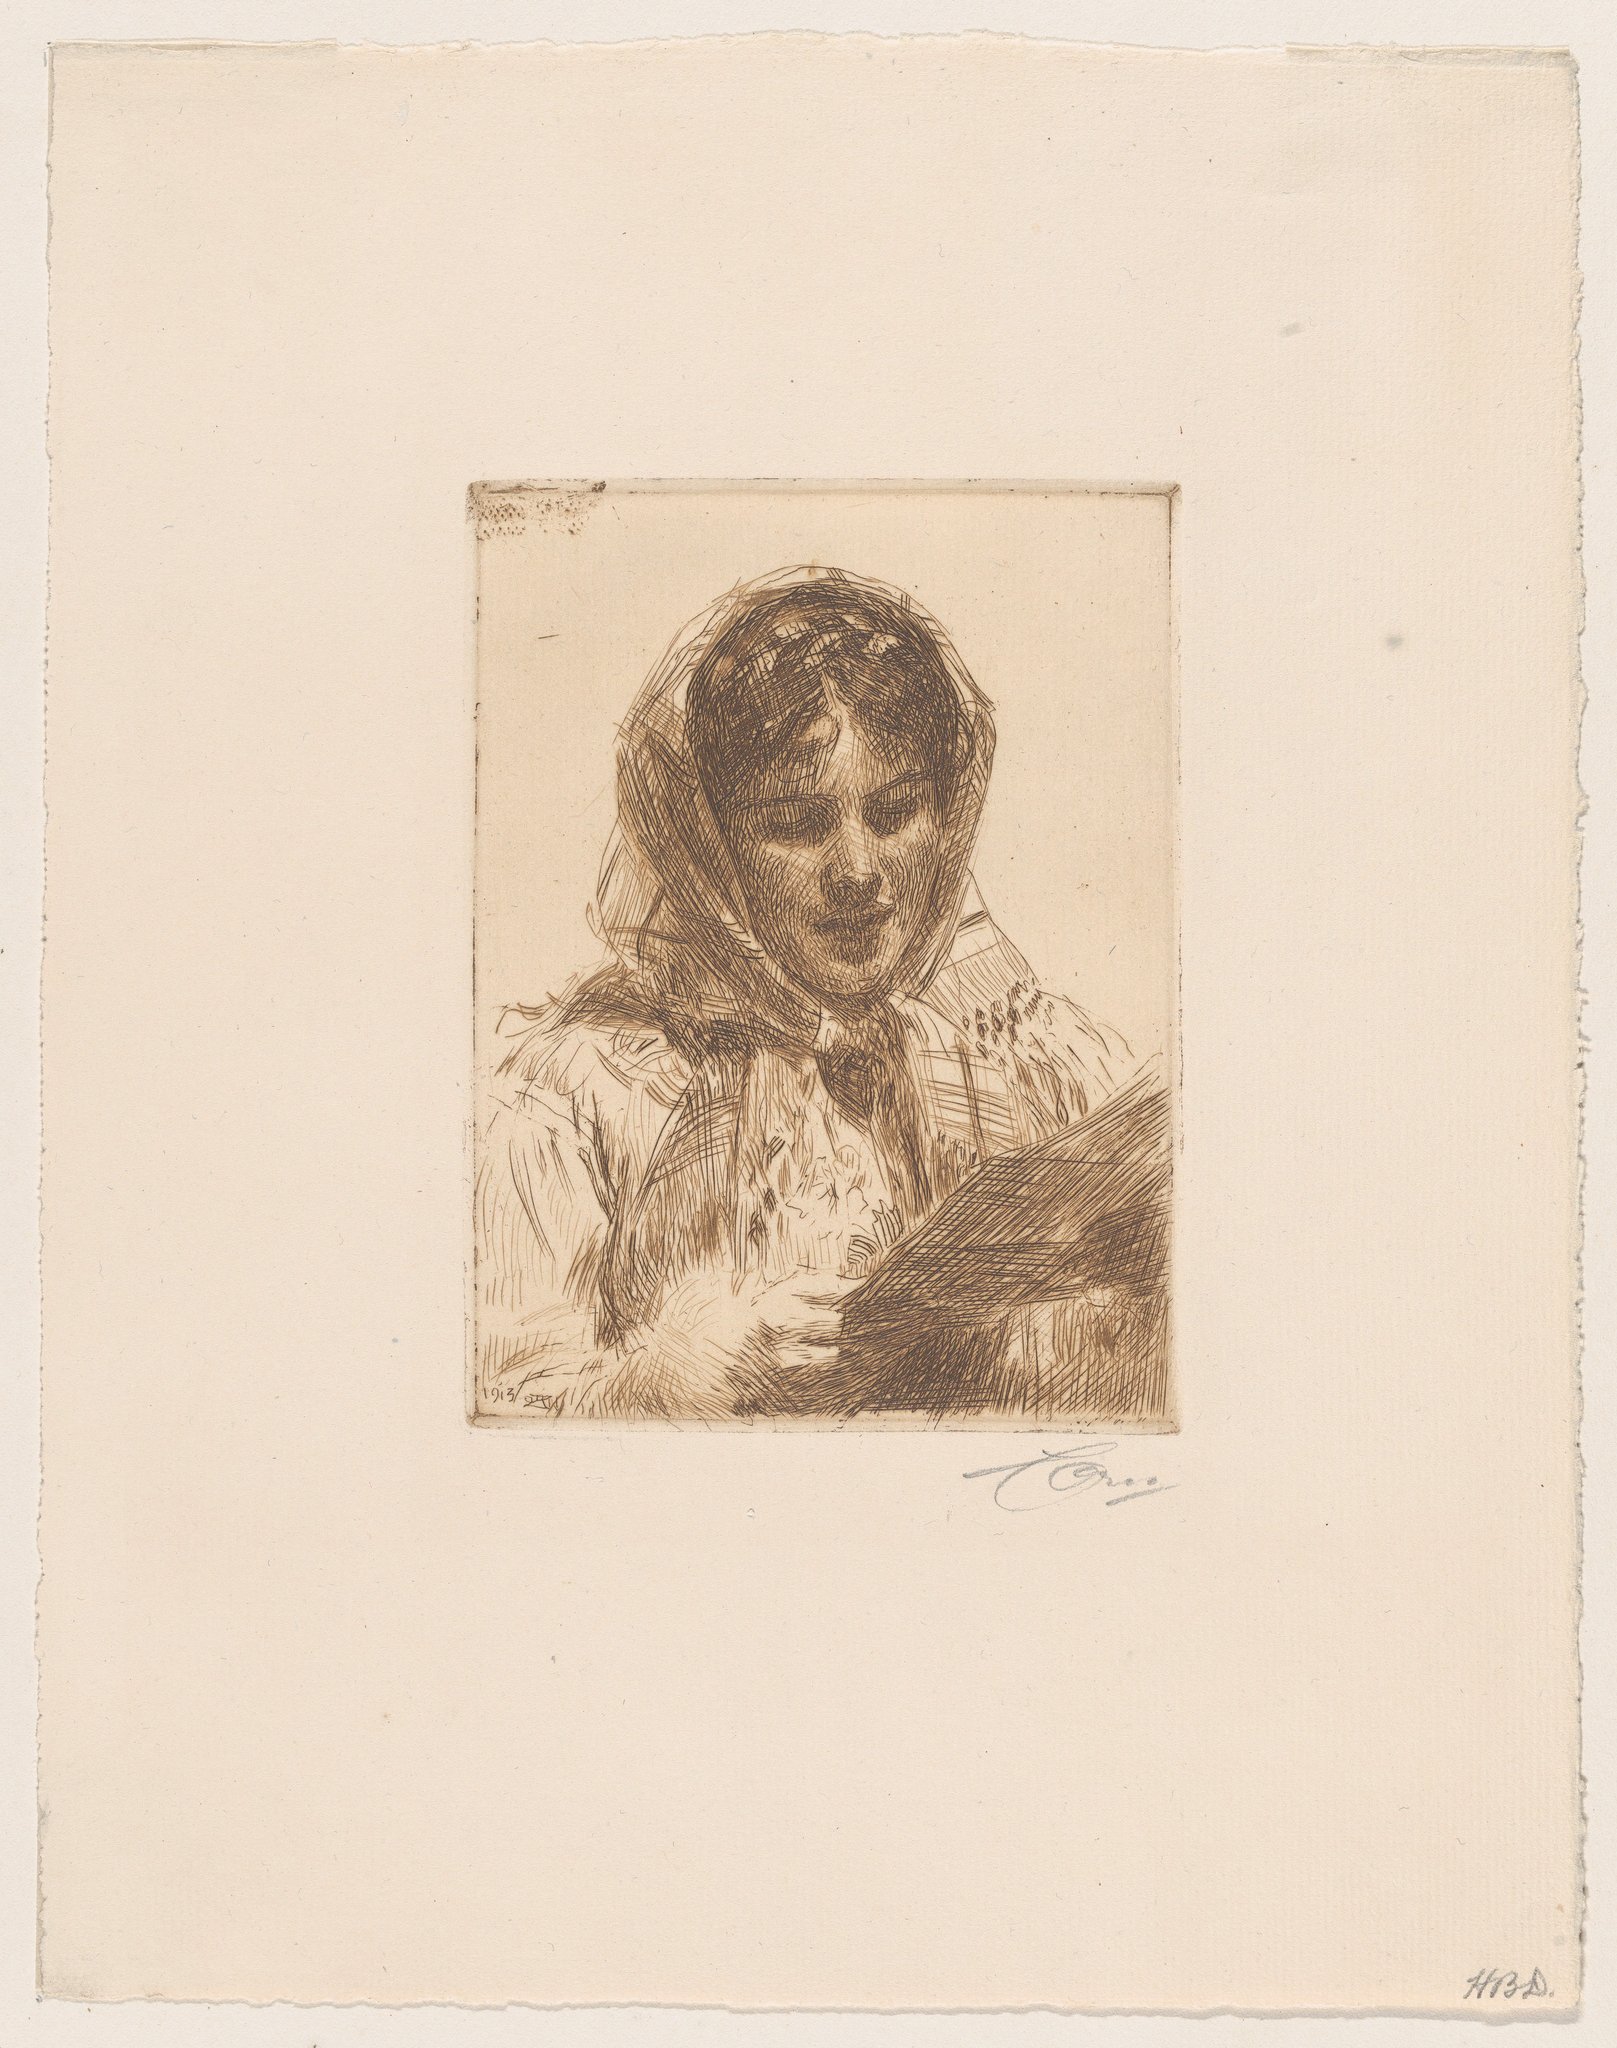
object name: print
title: The Letter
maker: anders zorn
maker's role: artist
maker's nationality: swedish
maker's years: 1860-1920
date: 1913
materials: ink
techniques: etching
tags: women,reading